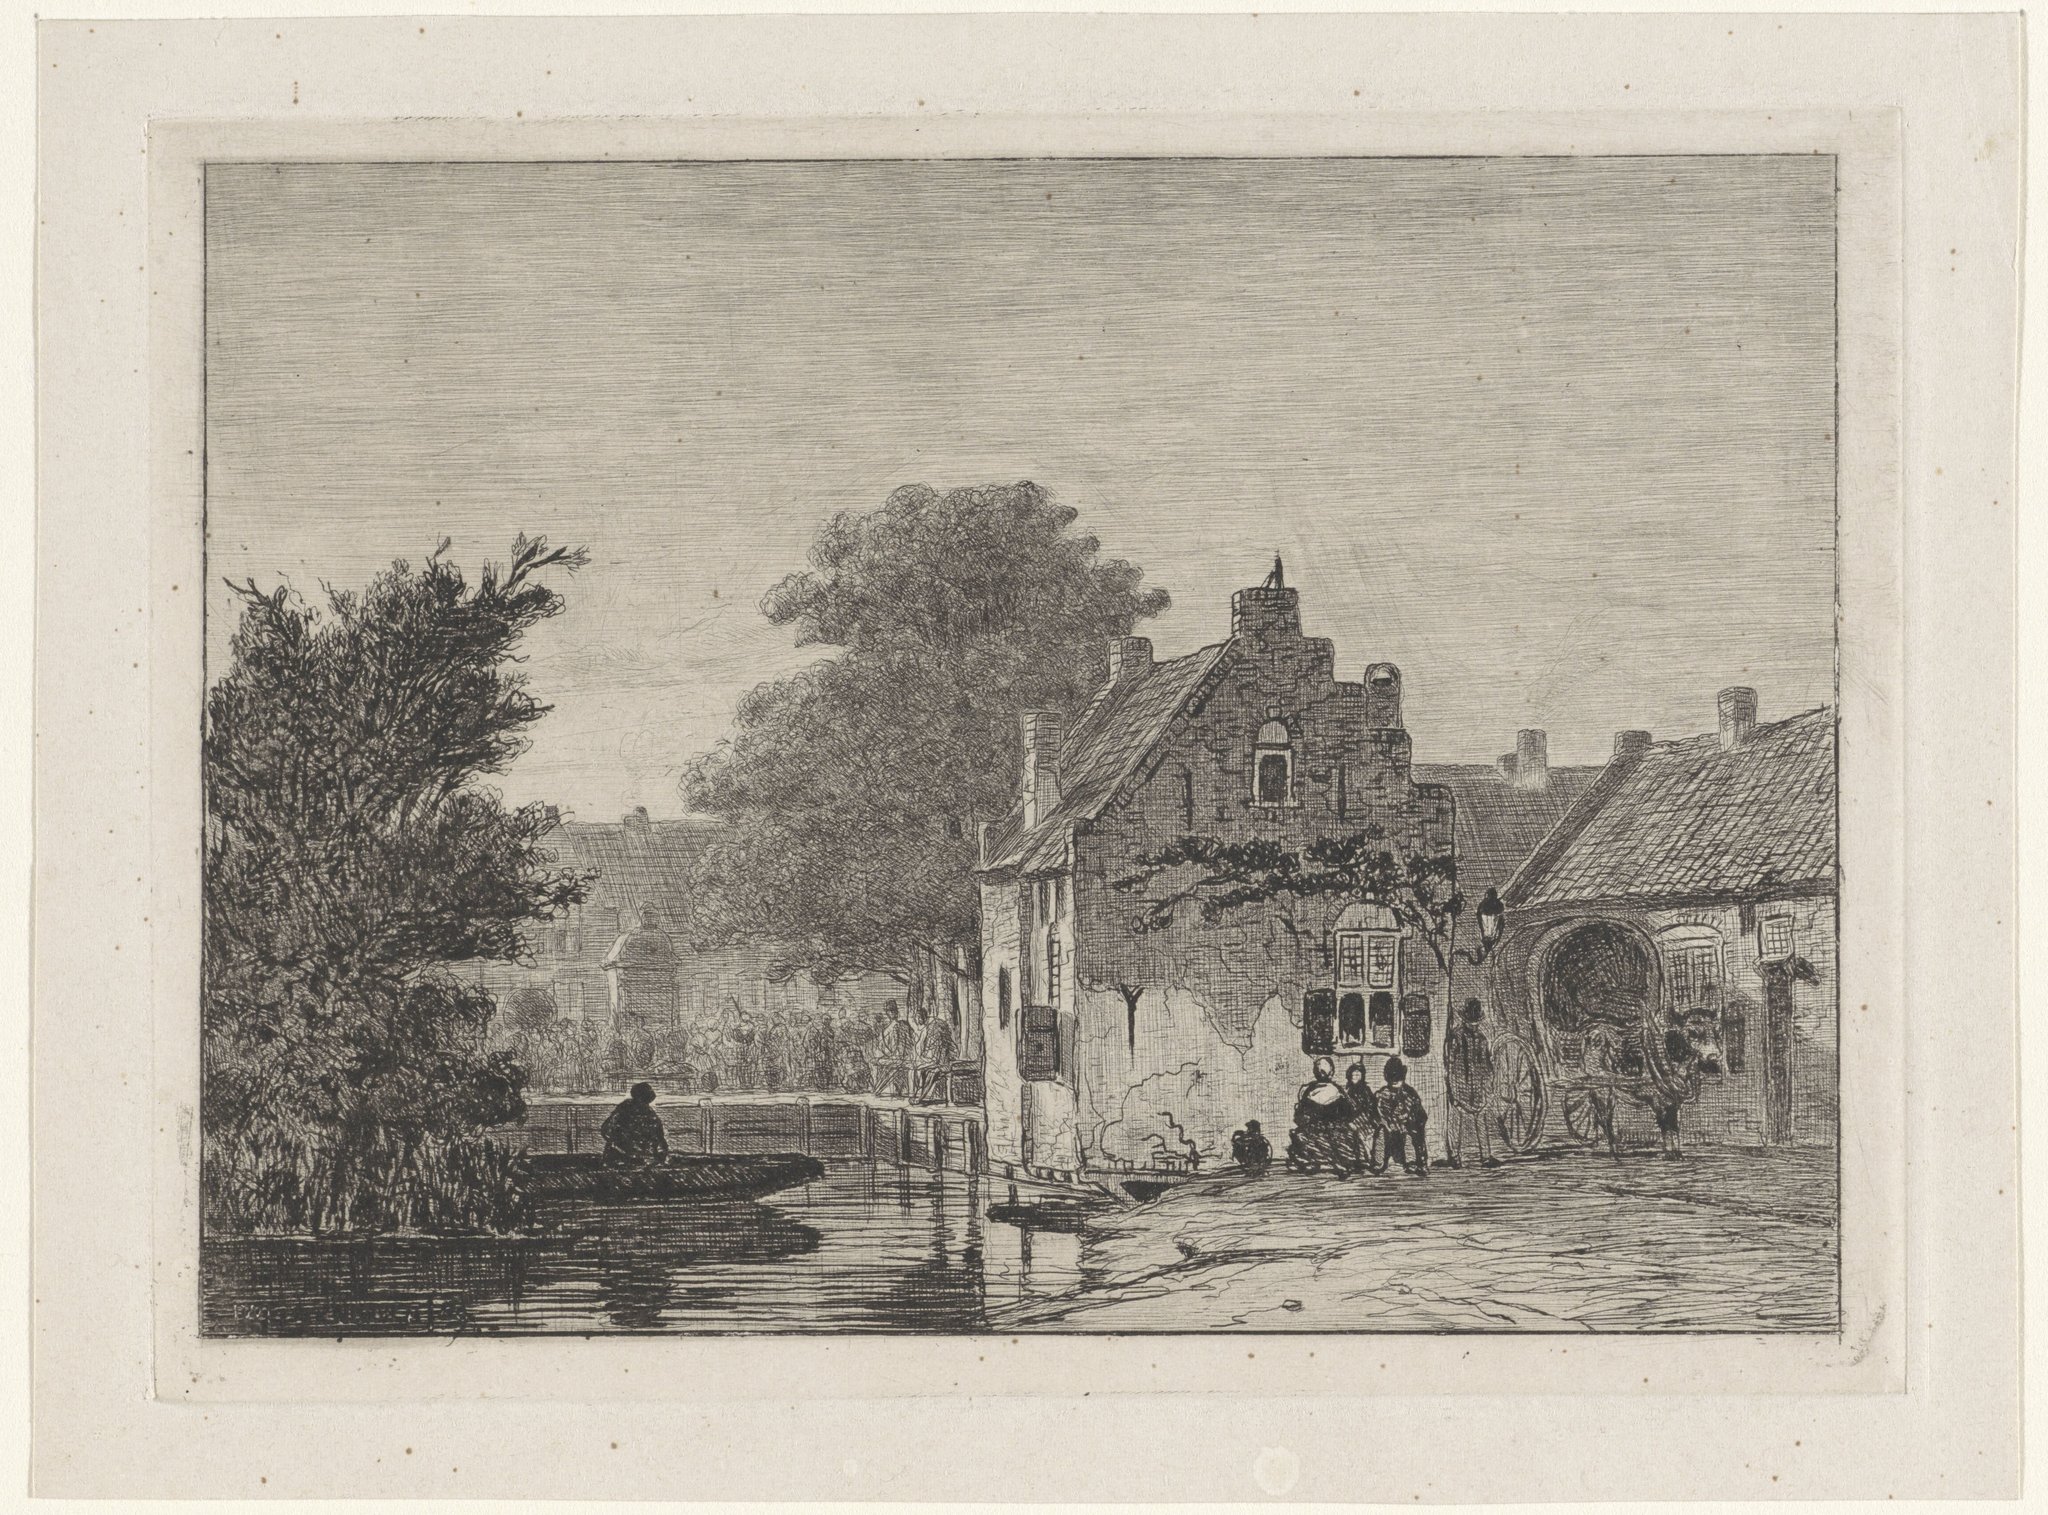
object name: print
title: Markt te Boxtel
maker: jan weissenbruch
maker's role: painter, print maker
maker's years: 1822-1880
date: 1849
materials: paper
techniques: etching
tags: urban housing, city-view, and landscape with man-made constructions, trees, adult woman, adult man, canal, rowing-boat, canoe, etc., horse, market, (farm) wagon, freight wagon, cart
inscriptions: collector's mark: Lugt 2228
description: In de verte is een druk marktplein te zien. Links vaart een man in een boot over een klein kanaal. Rechts zitten enkele figuren voor een huis met een trapgevel. Op de weg ernaast staat een paard-en-wagen.